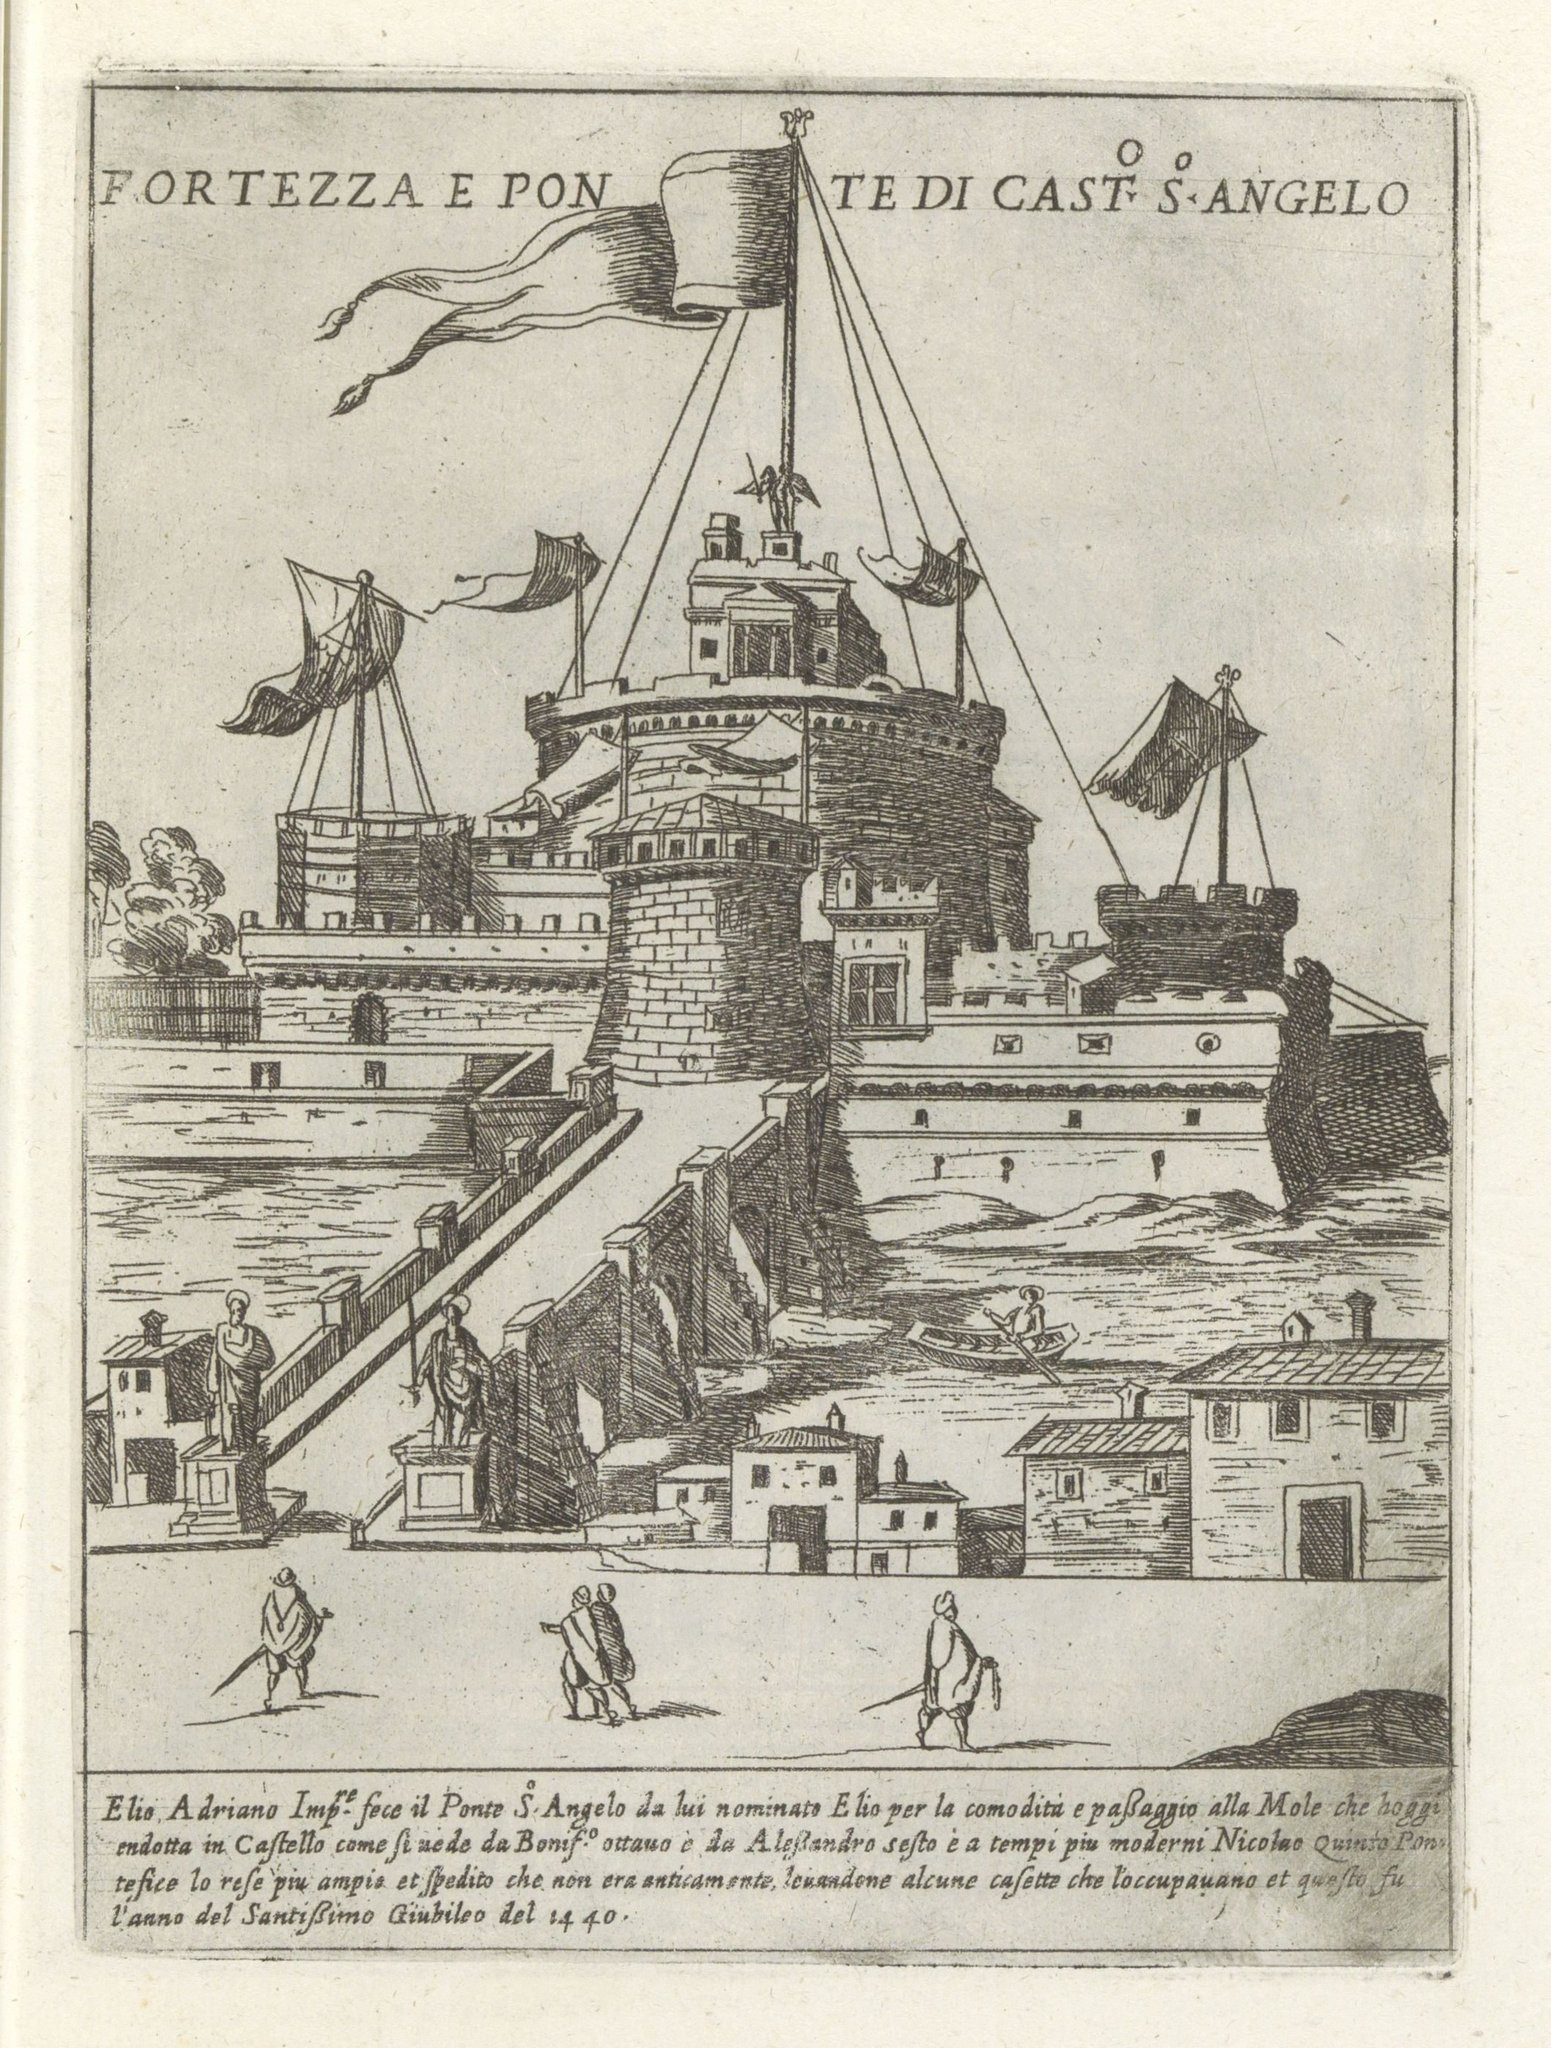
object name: album leaf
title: Ornamenti di fabriche antichi et moderni dell' alma citta di Roma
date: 1576-1618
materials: paper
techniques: etching, intaglio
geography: rome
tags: fortress, bridge, rome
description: Gezicht op de Engelenburcht en de Engelenbrug over de rivier de Tiber te Rome. Italiaanse tekst in ondermarge. De prent maakt deel uit van een album.